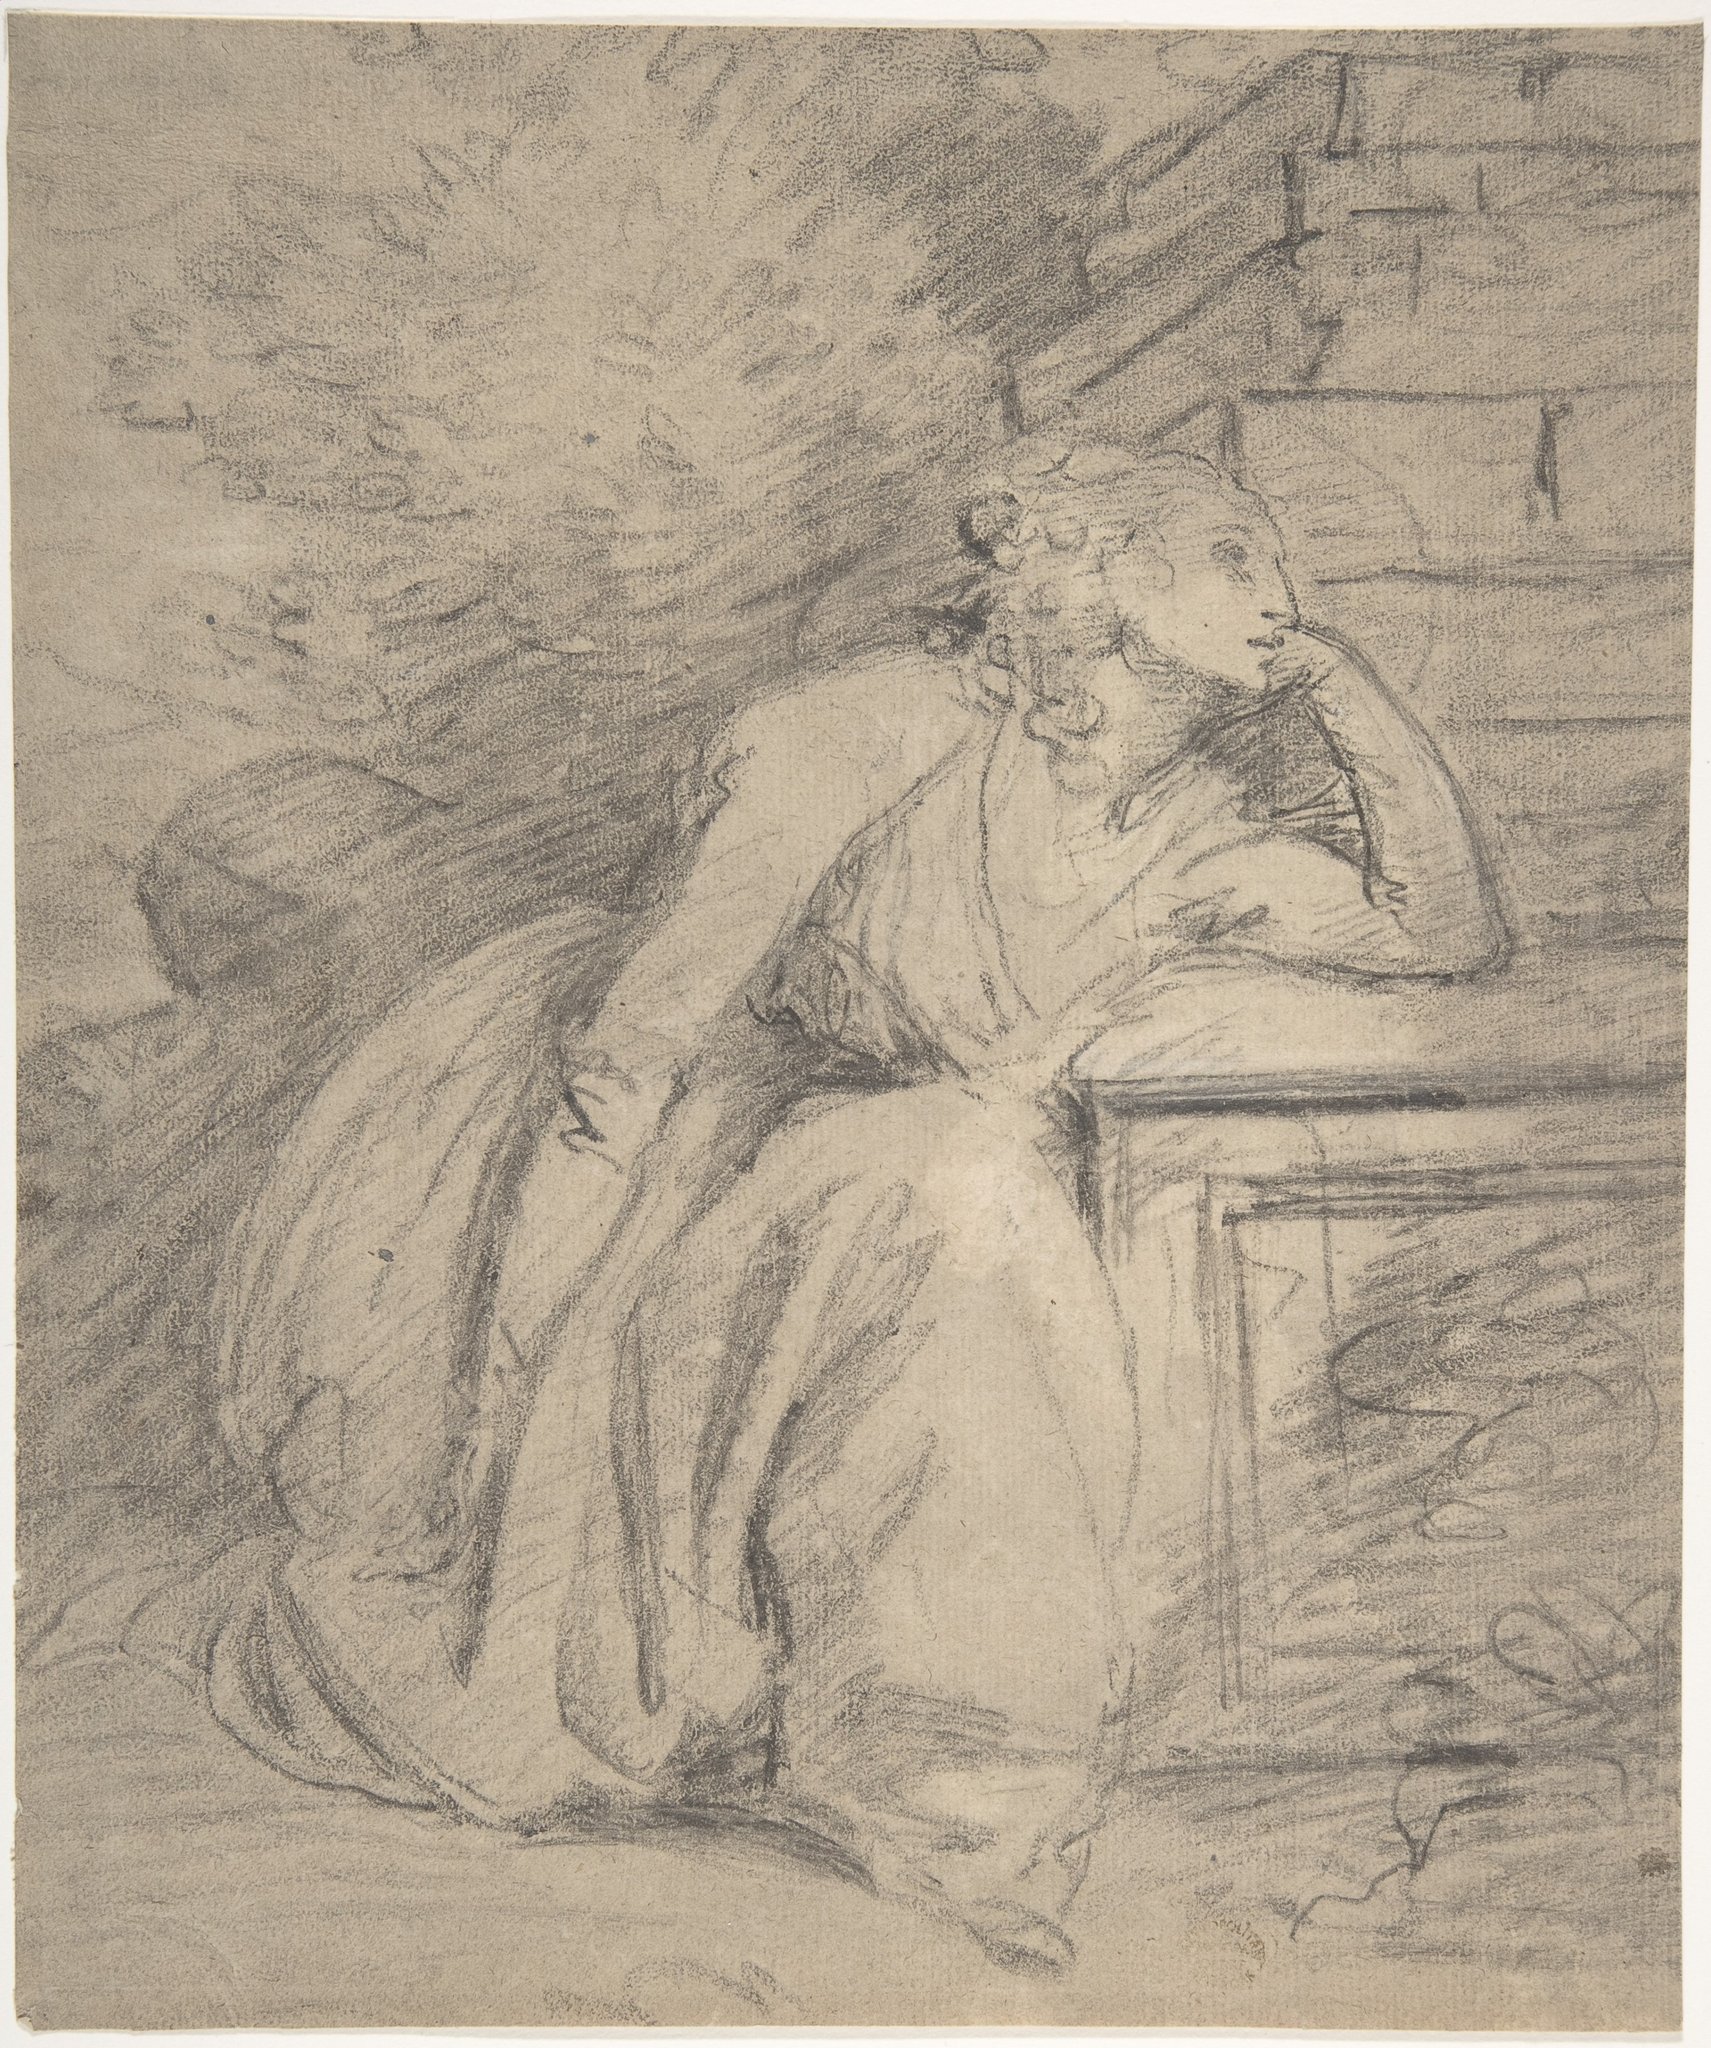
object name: drawing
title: Study of a Seated Woman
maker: john hoppner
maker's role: artist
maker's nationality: british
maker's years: 1758-1810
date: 1778-1810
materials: chalk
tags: women